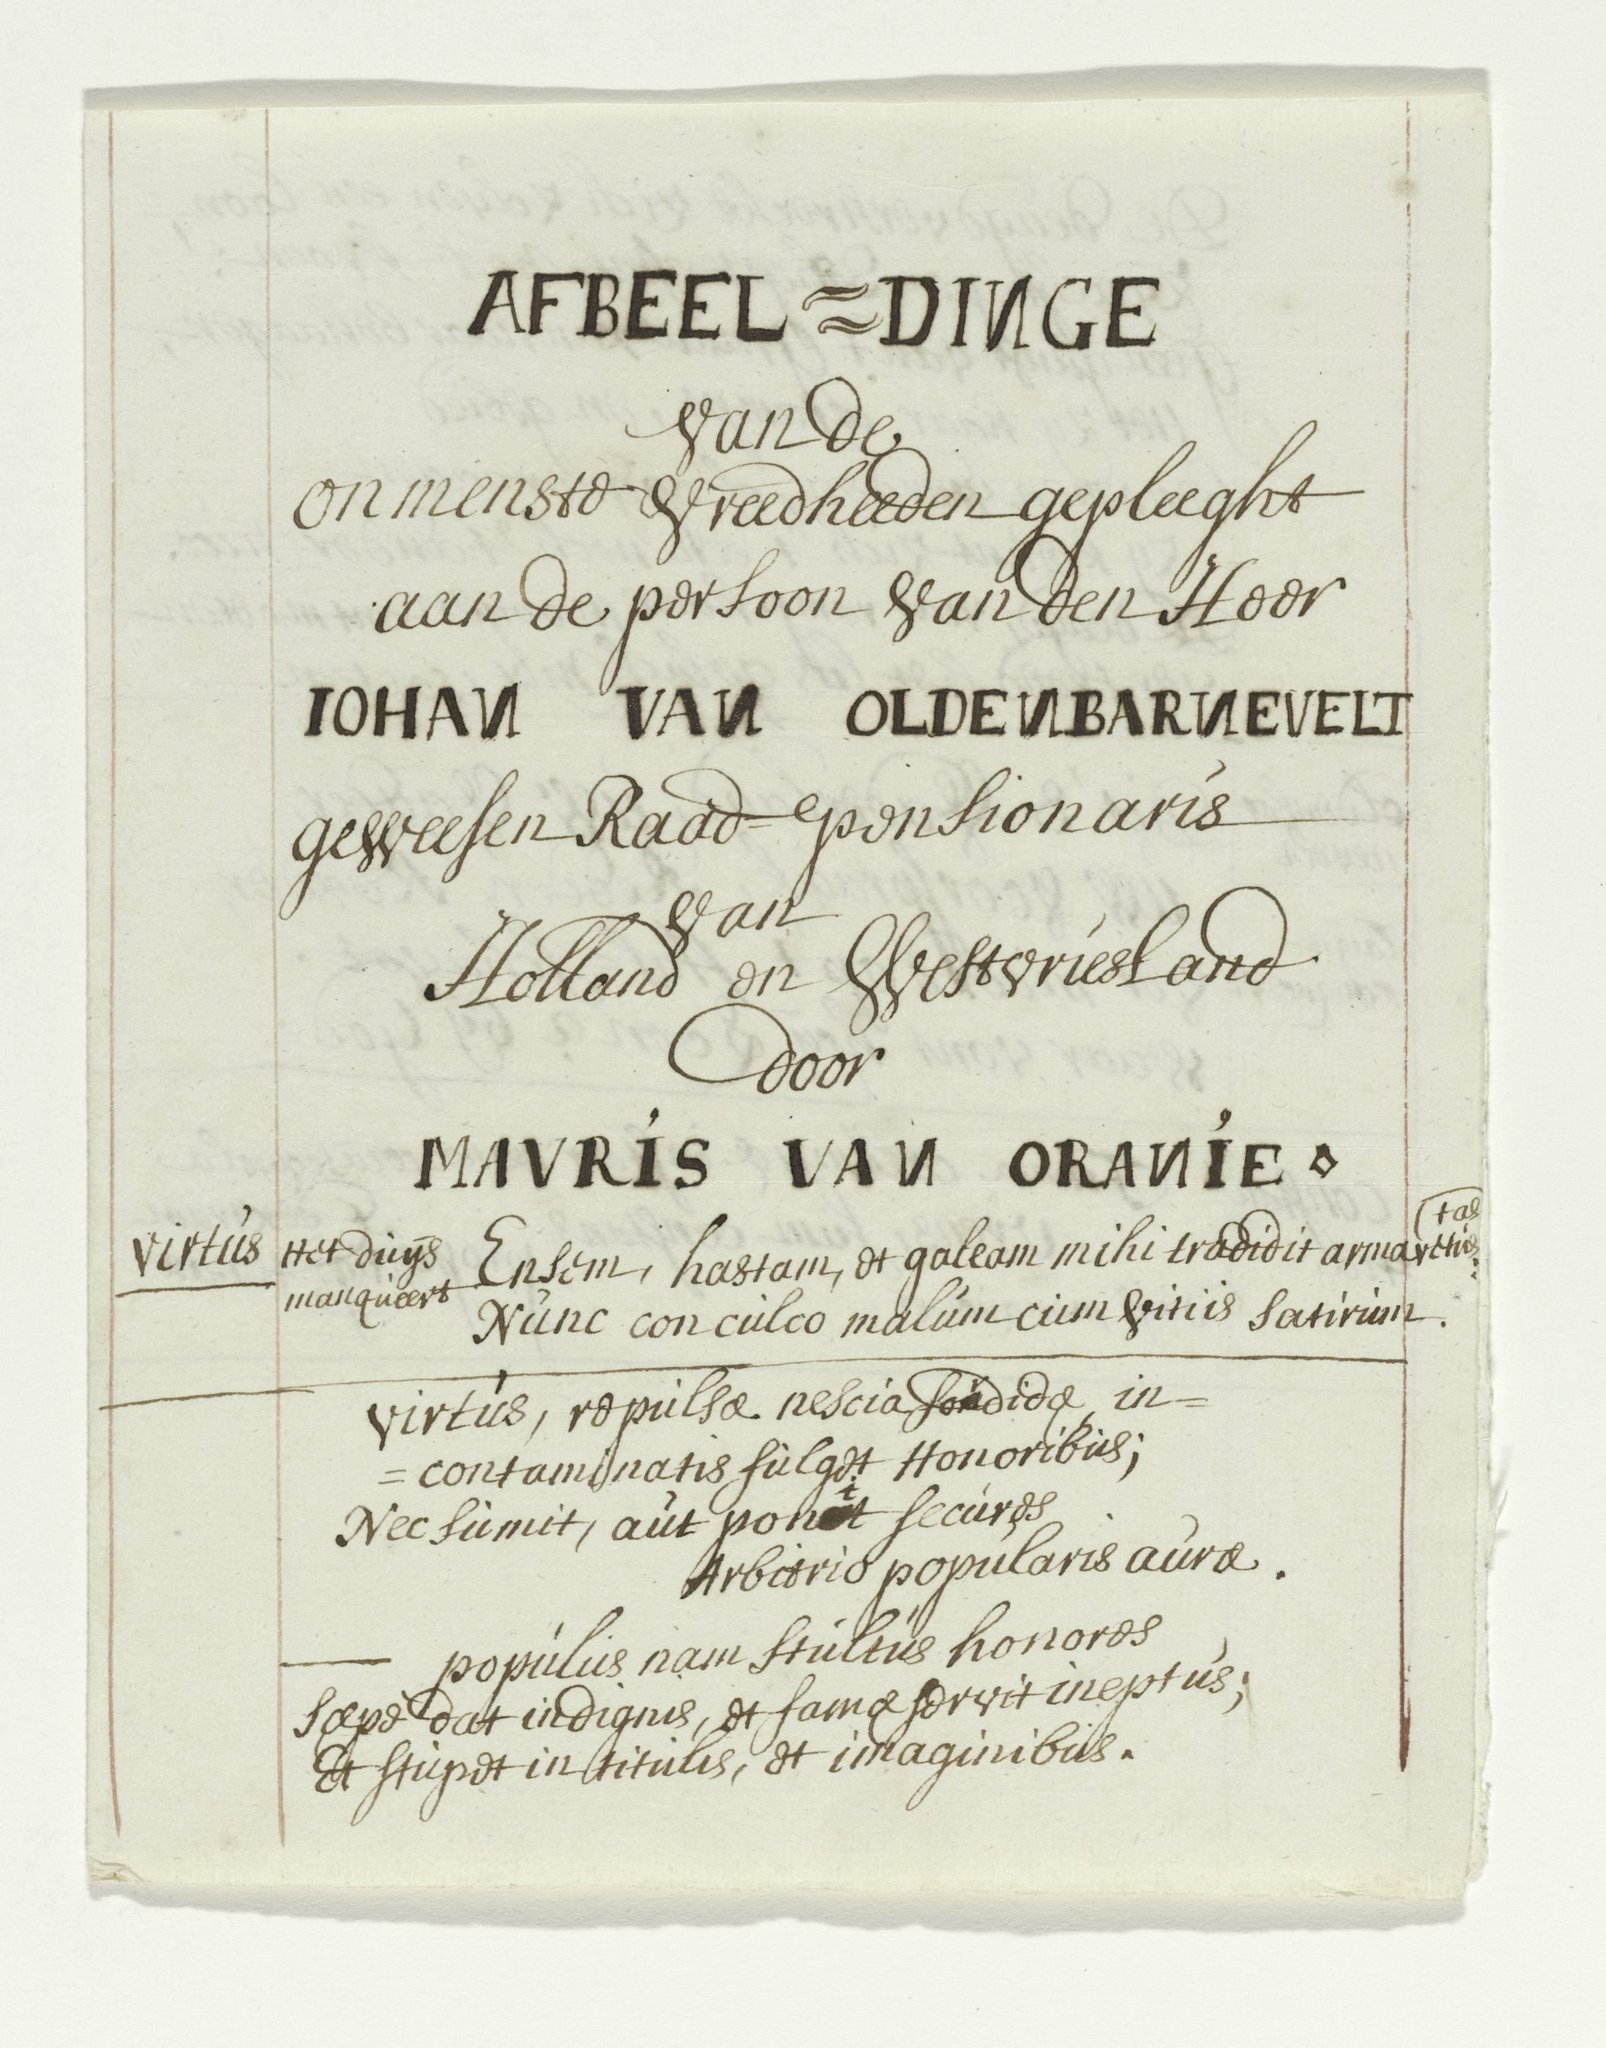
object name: manuscript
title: Regtspleging van Oldenbarnevelt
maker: Anonymous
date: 1710-1720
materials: paper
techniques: pen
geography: netherlands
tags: the hague, johan van oldenbarnevelt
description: Twee kleine dubbelgevouwen bladen en een groter blad met geschreven toelichtingen op de voorstelling van de tekening van de triomfpoort 'Dits vaderland, uw vader...'. Behorende bij serie aquarellen in boek.